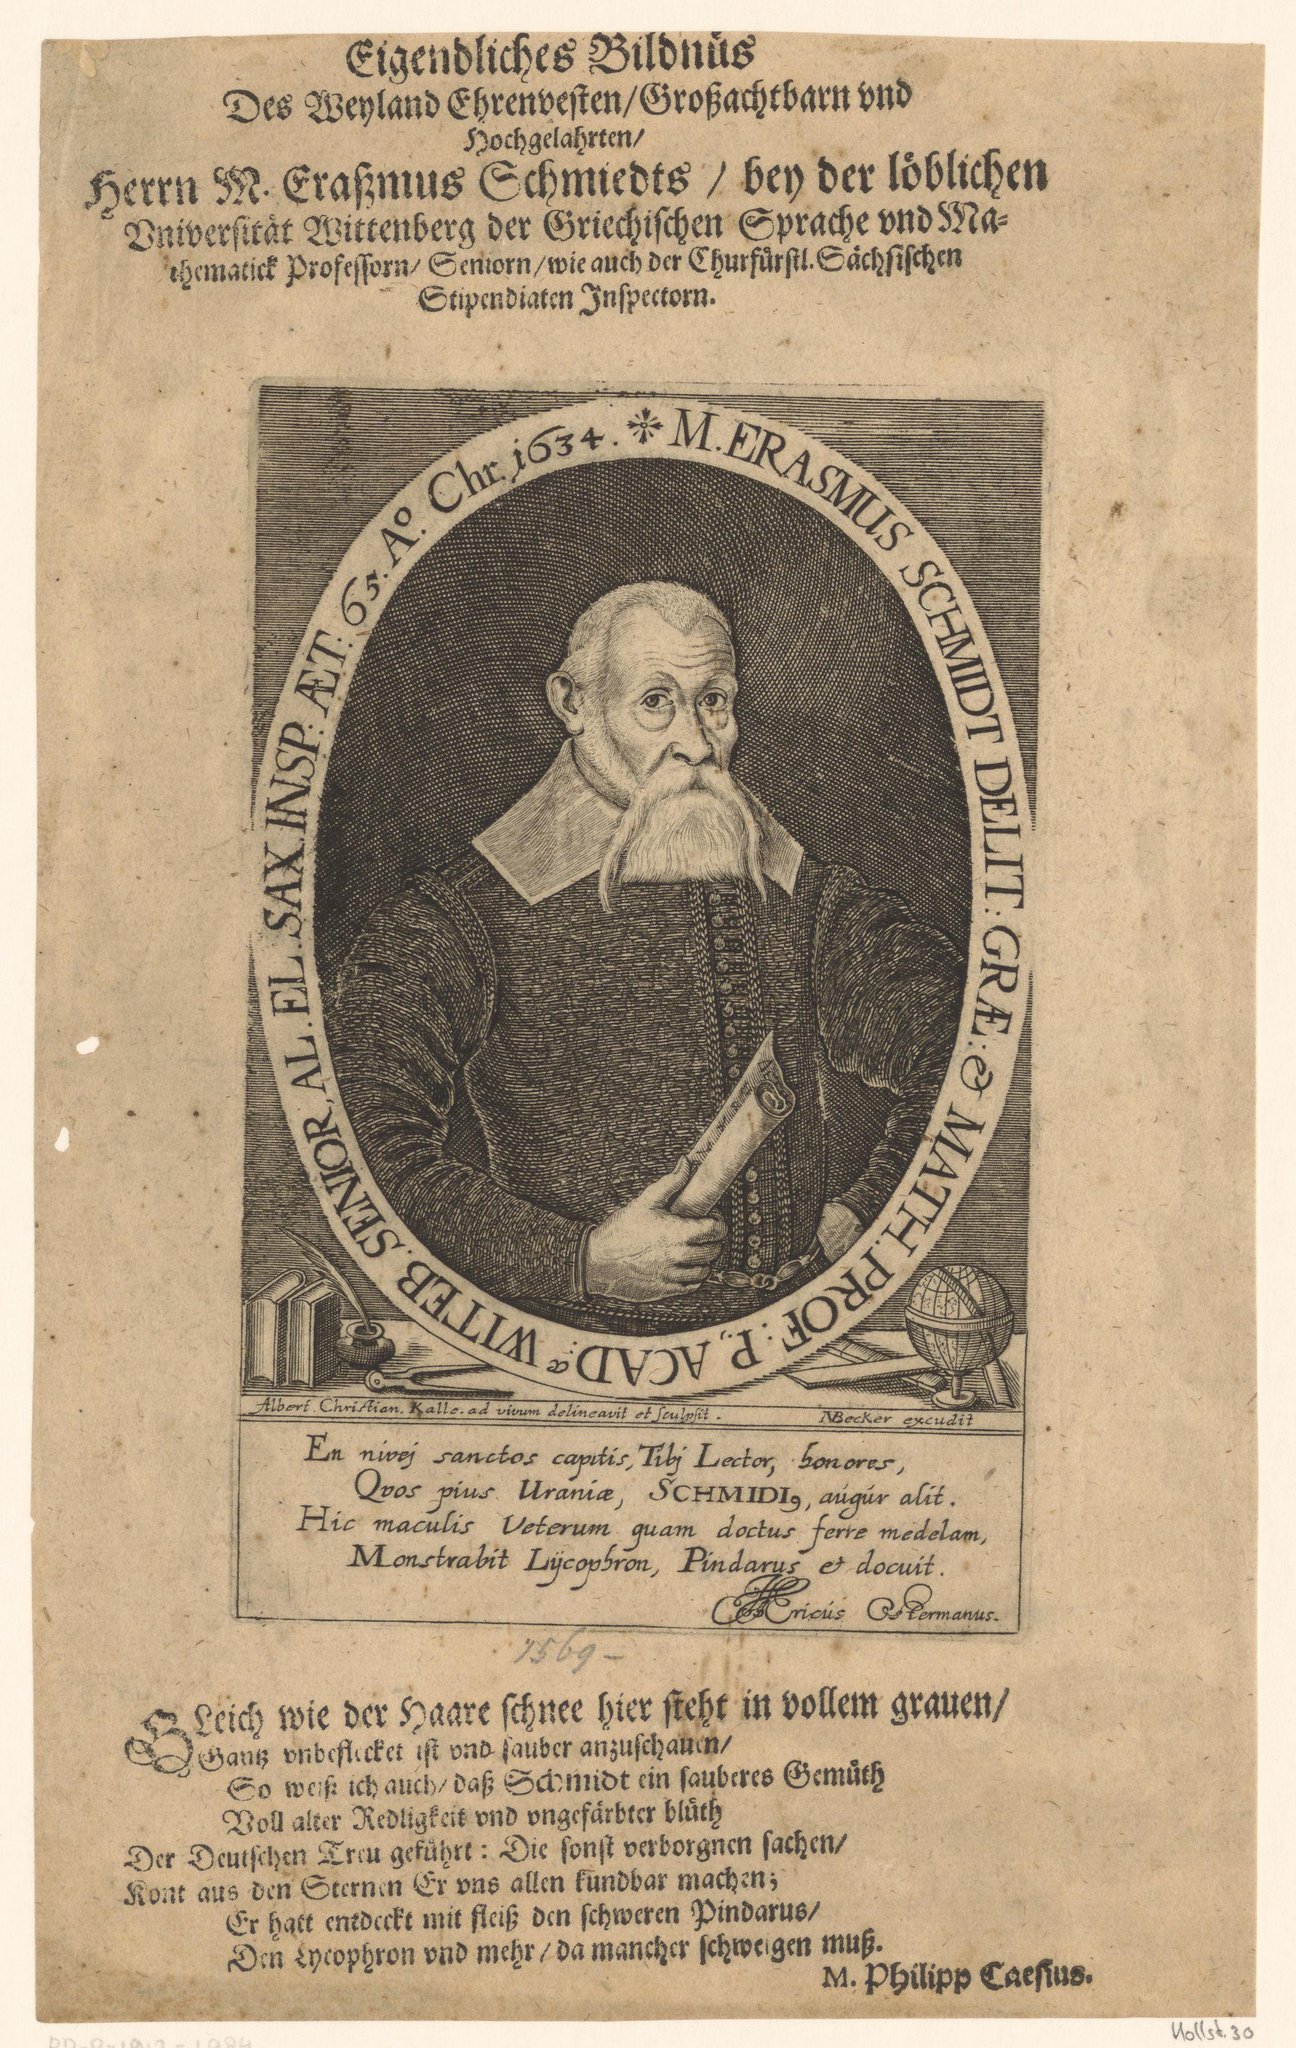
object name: print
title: Portret van Erasmus Schmidt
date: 1630-1670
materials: paper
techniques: engraving, etching, letterpress printing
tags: historical persons, physician, doctor (+ portrait of scholar, scientist)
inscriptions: collector's mark: Lugt 2228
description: Tekst in het Latijn in de omlijsting en de marges, en tekst in het Duits in boekdruk op het blad.